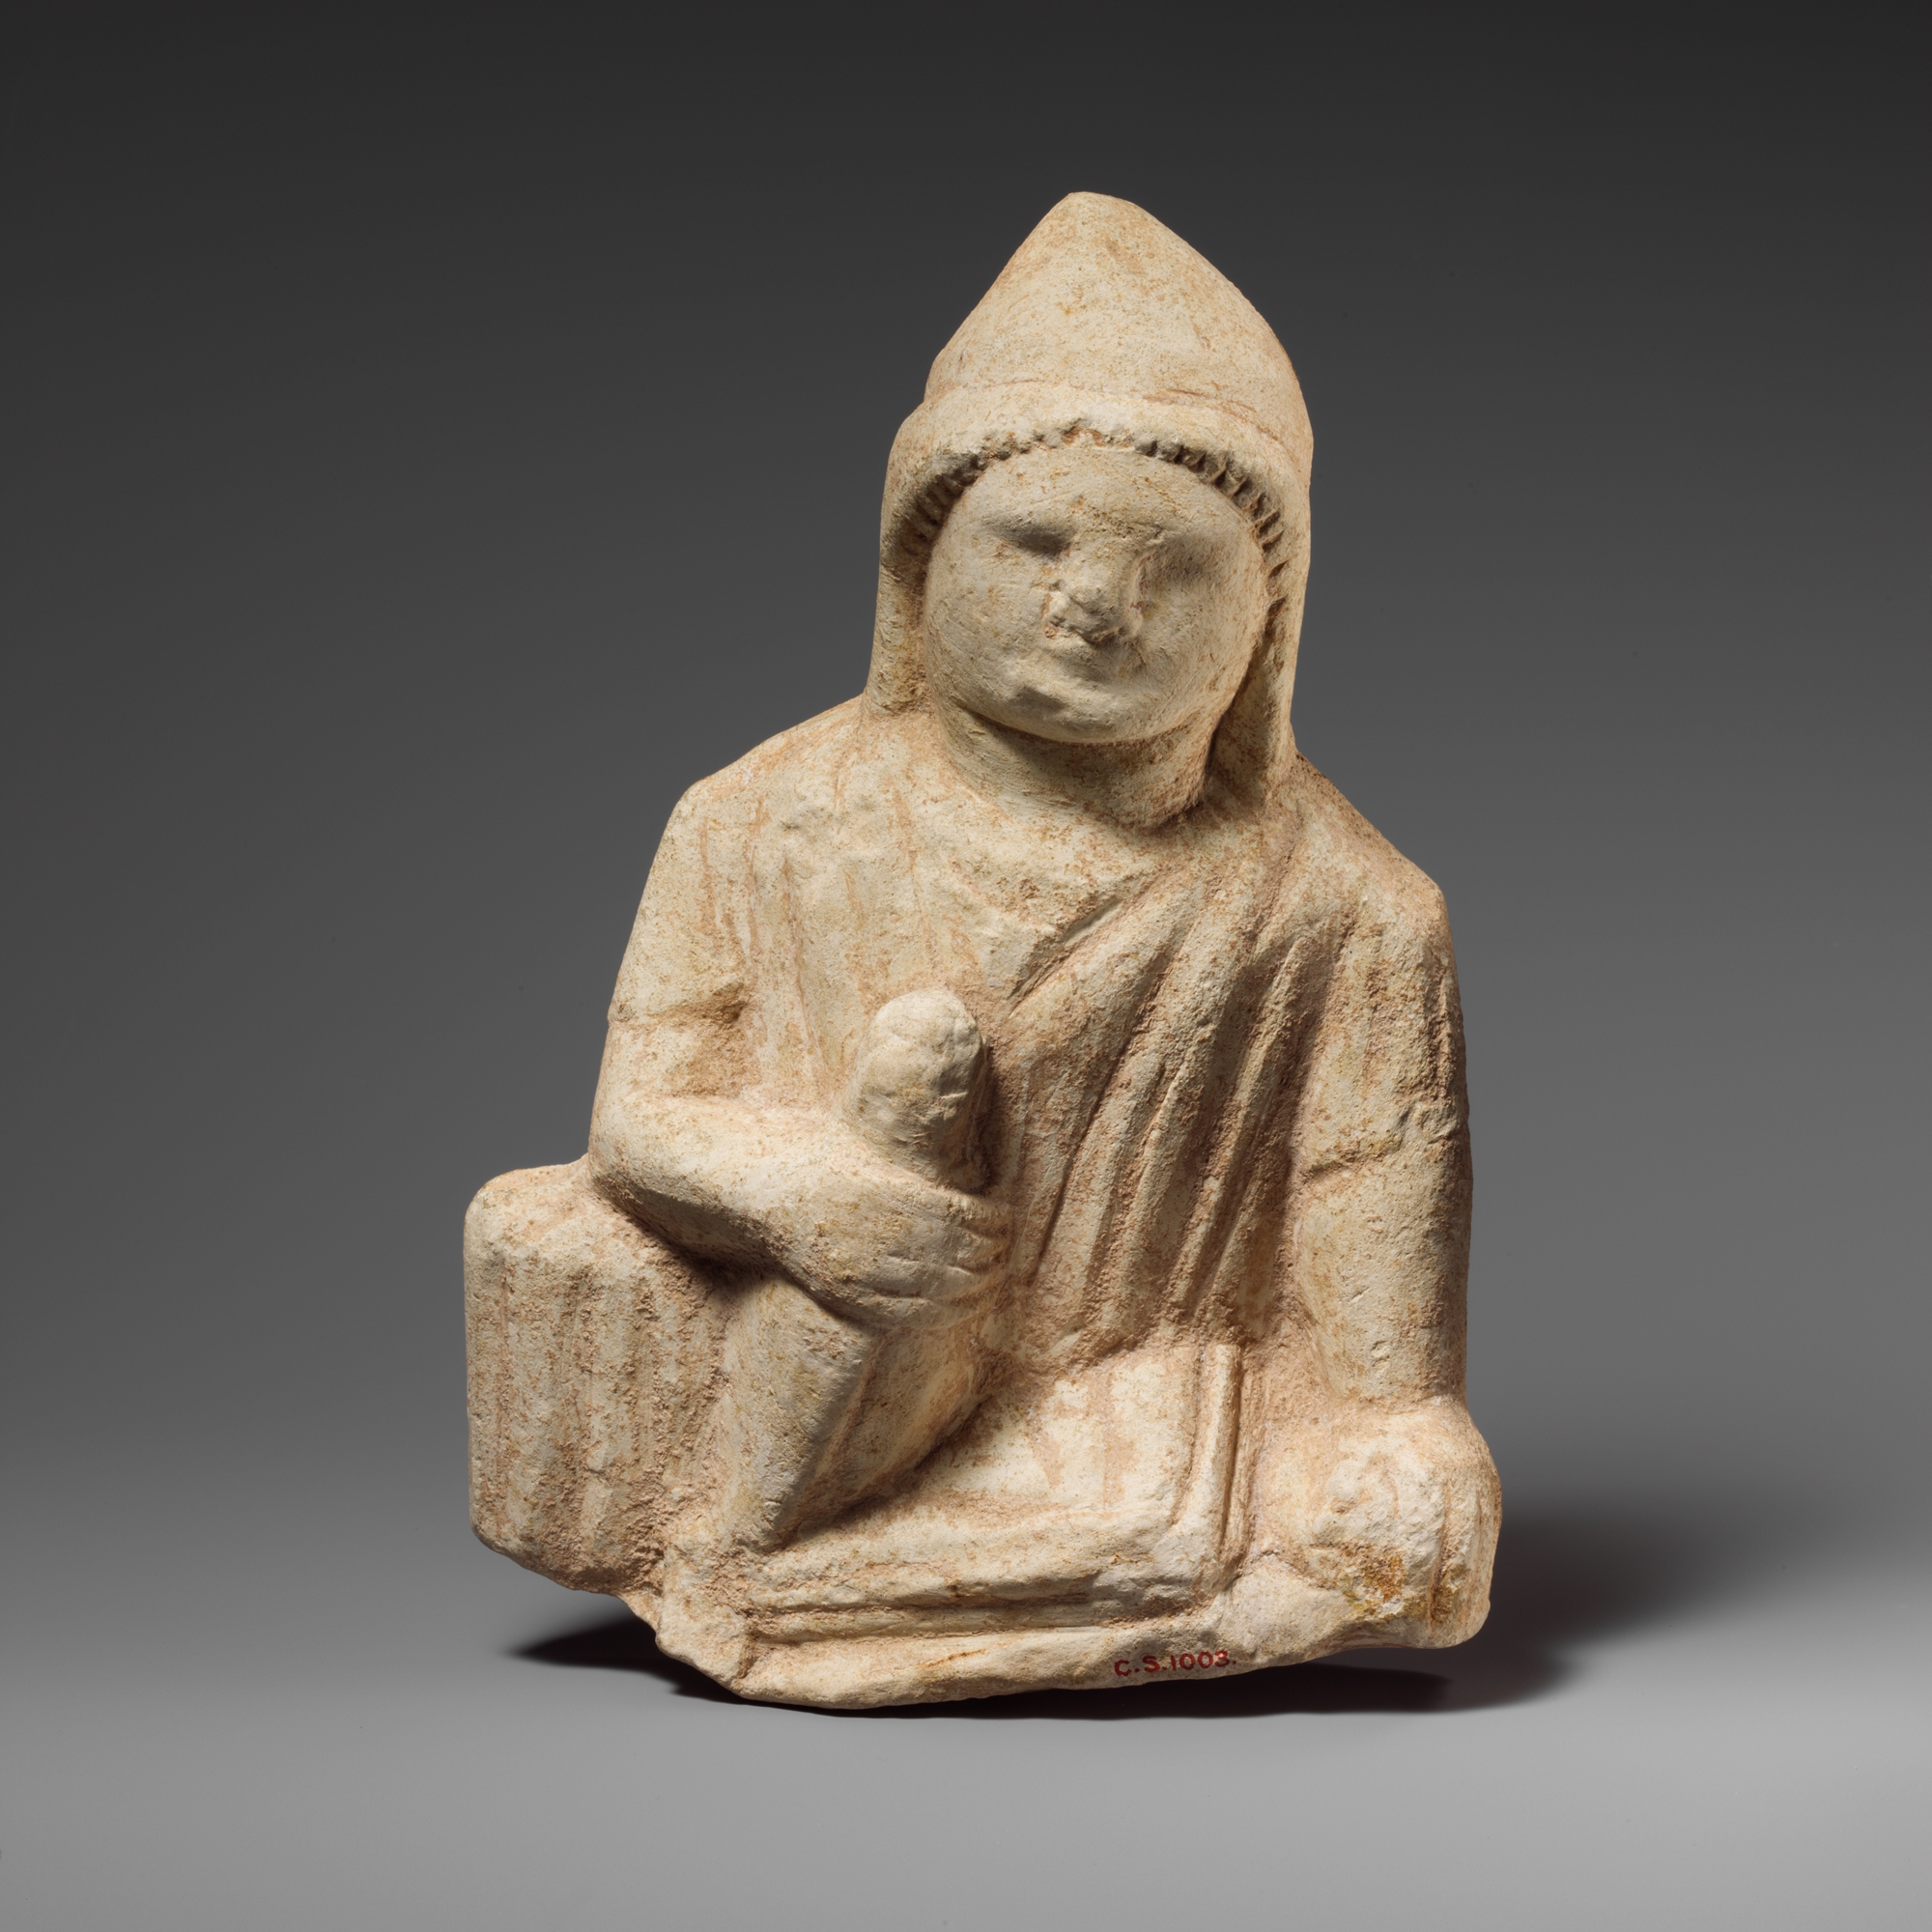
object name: statuette of a temple boy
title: Limestone statuette of a temple boy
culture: cypriot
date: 400-301 BCE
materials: limestone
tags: birds,boys